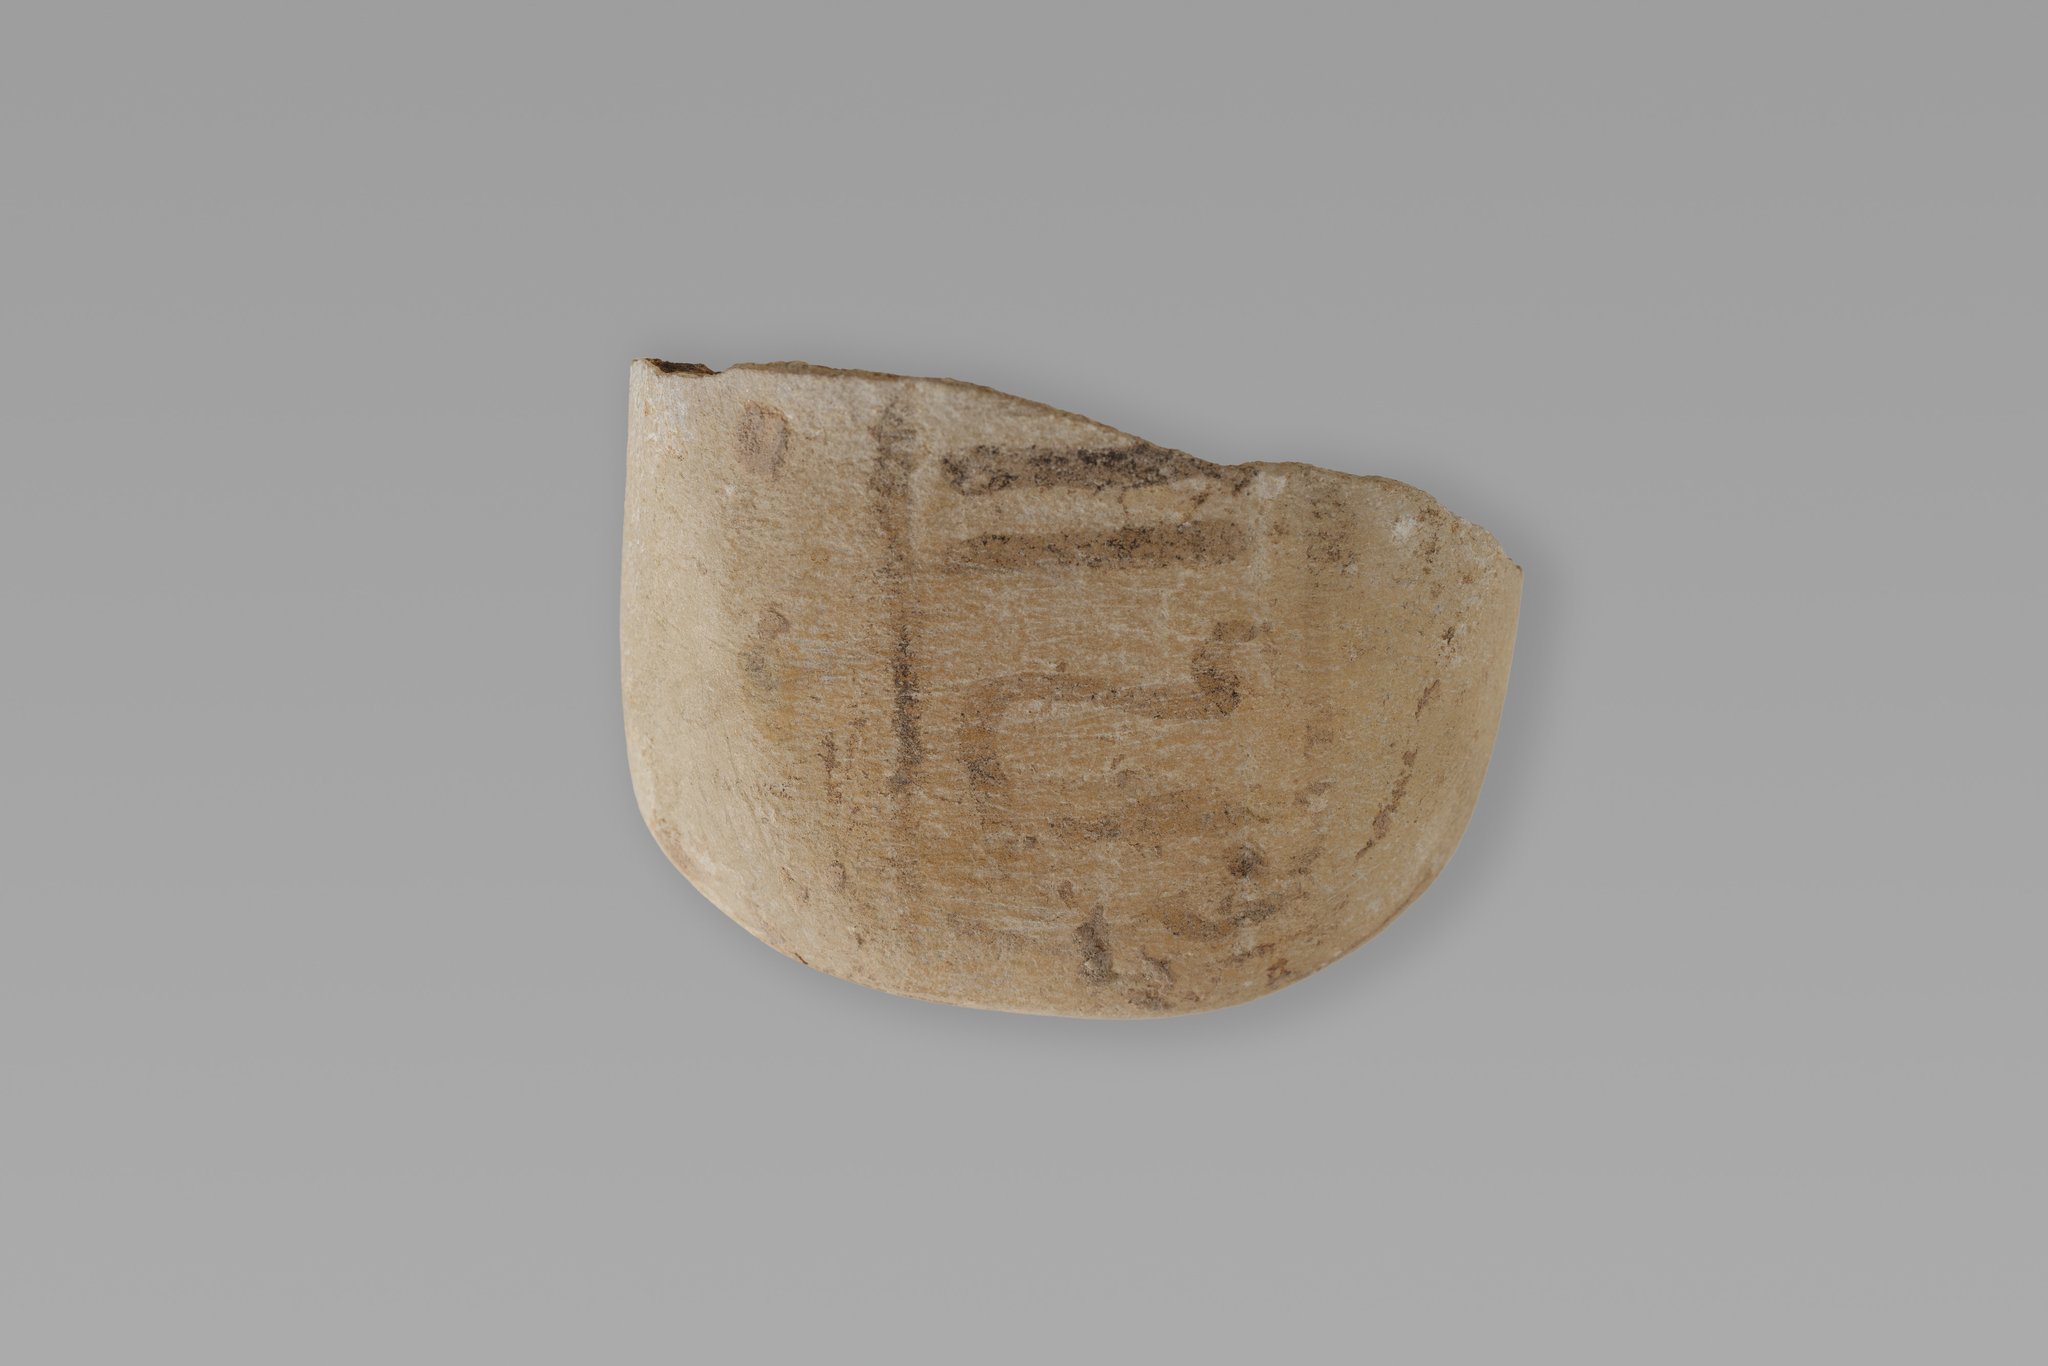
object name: shabti, siptah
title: Shabti of Siptah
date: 1194-1188 BCE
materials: stone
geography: egypt